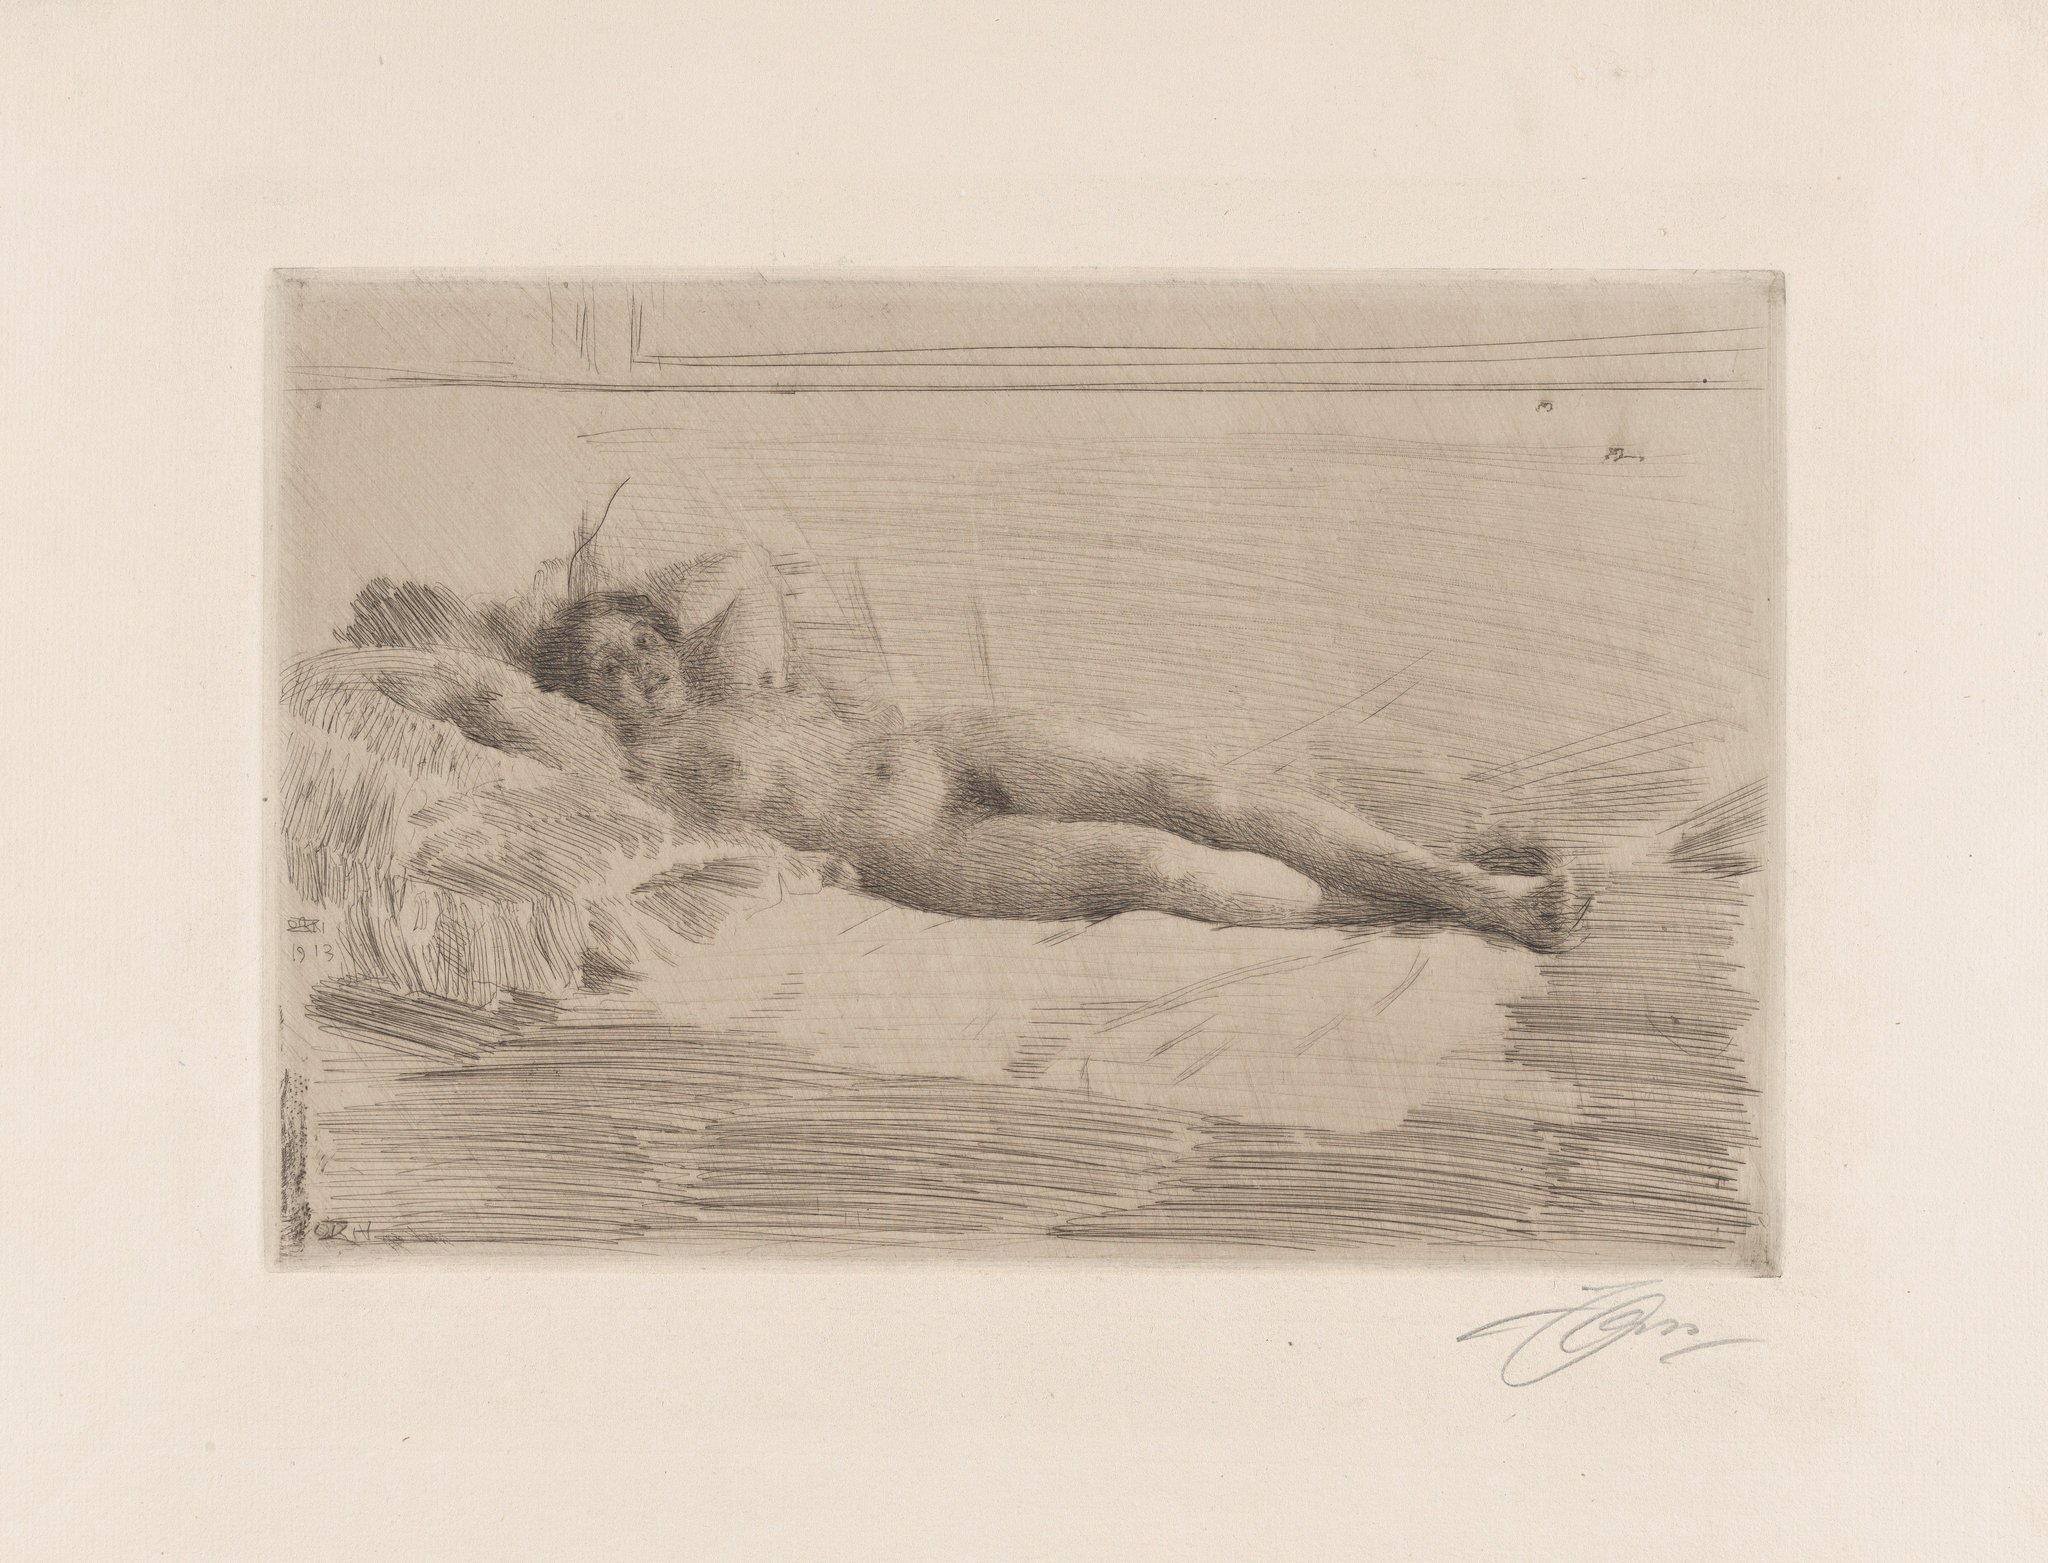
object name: print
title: Elin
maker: anders zorn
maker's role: artist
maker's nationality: swedish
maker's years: 1860-1920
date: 1913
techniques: etching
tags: female nudes